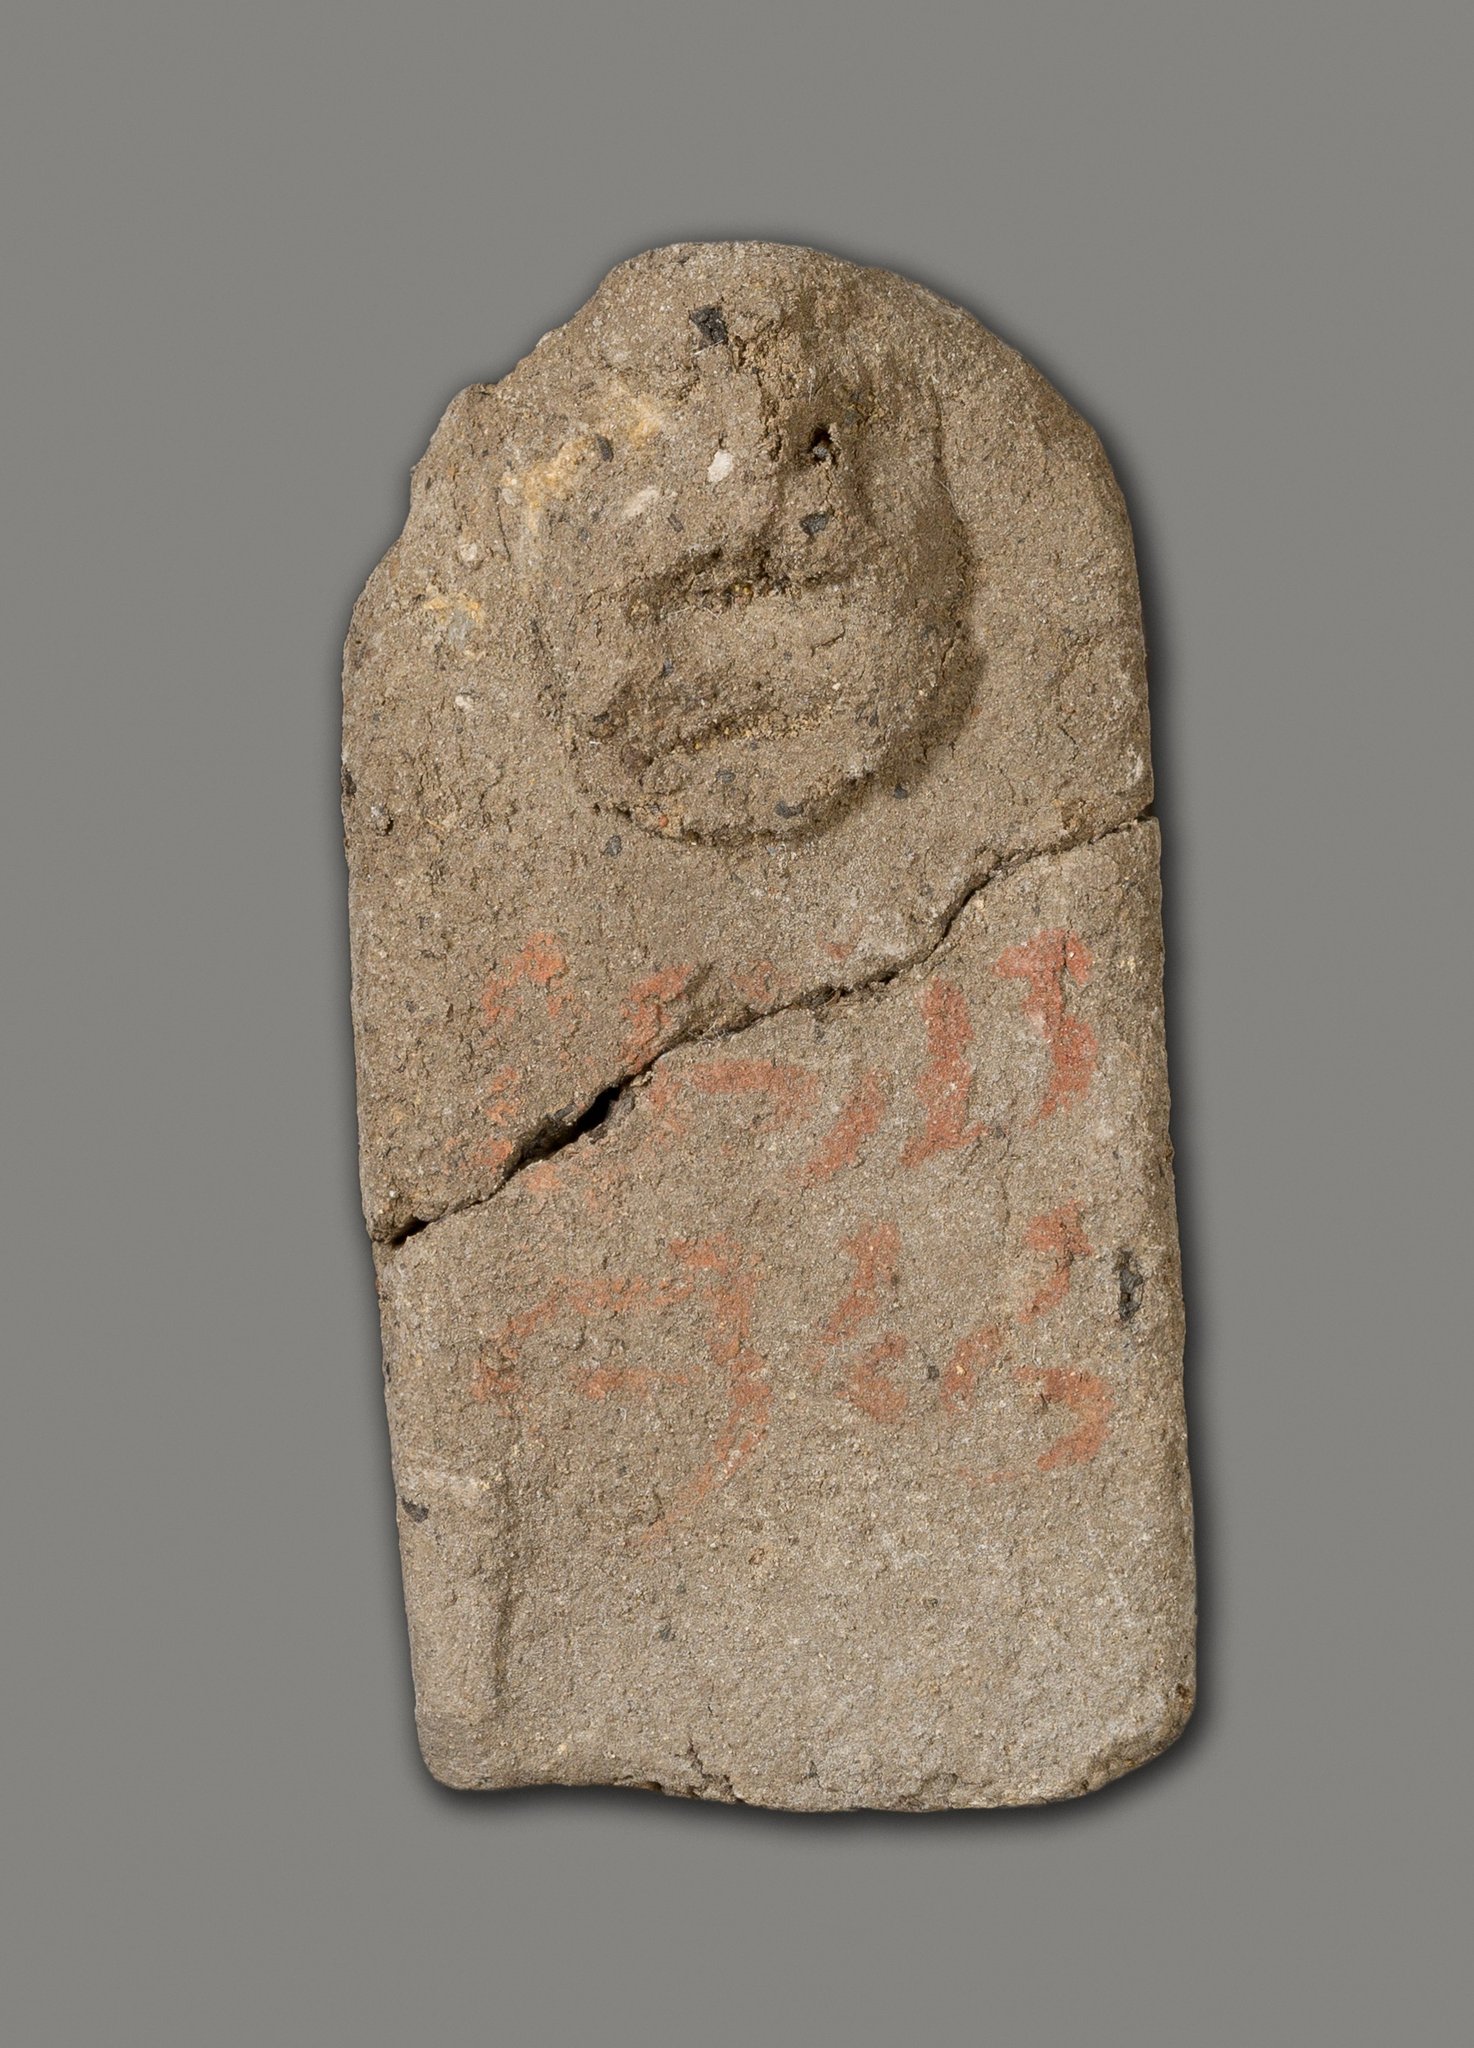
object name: figure, magical, execration, tablet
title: Magical Figure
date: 1802-1550 BCE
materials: clay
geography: egypt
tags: faces